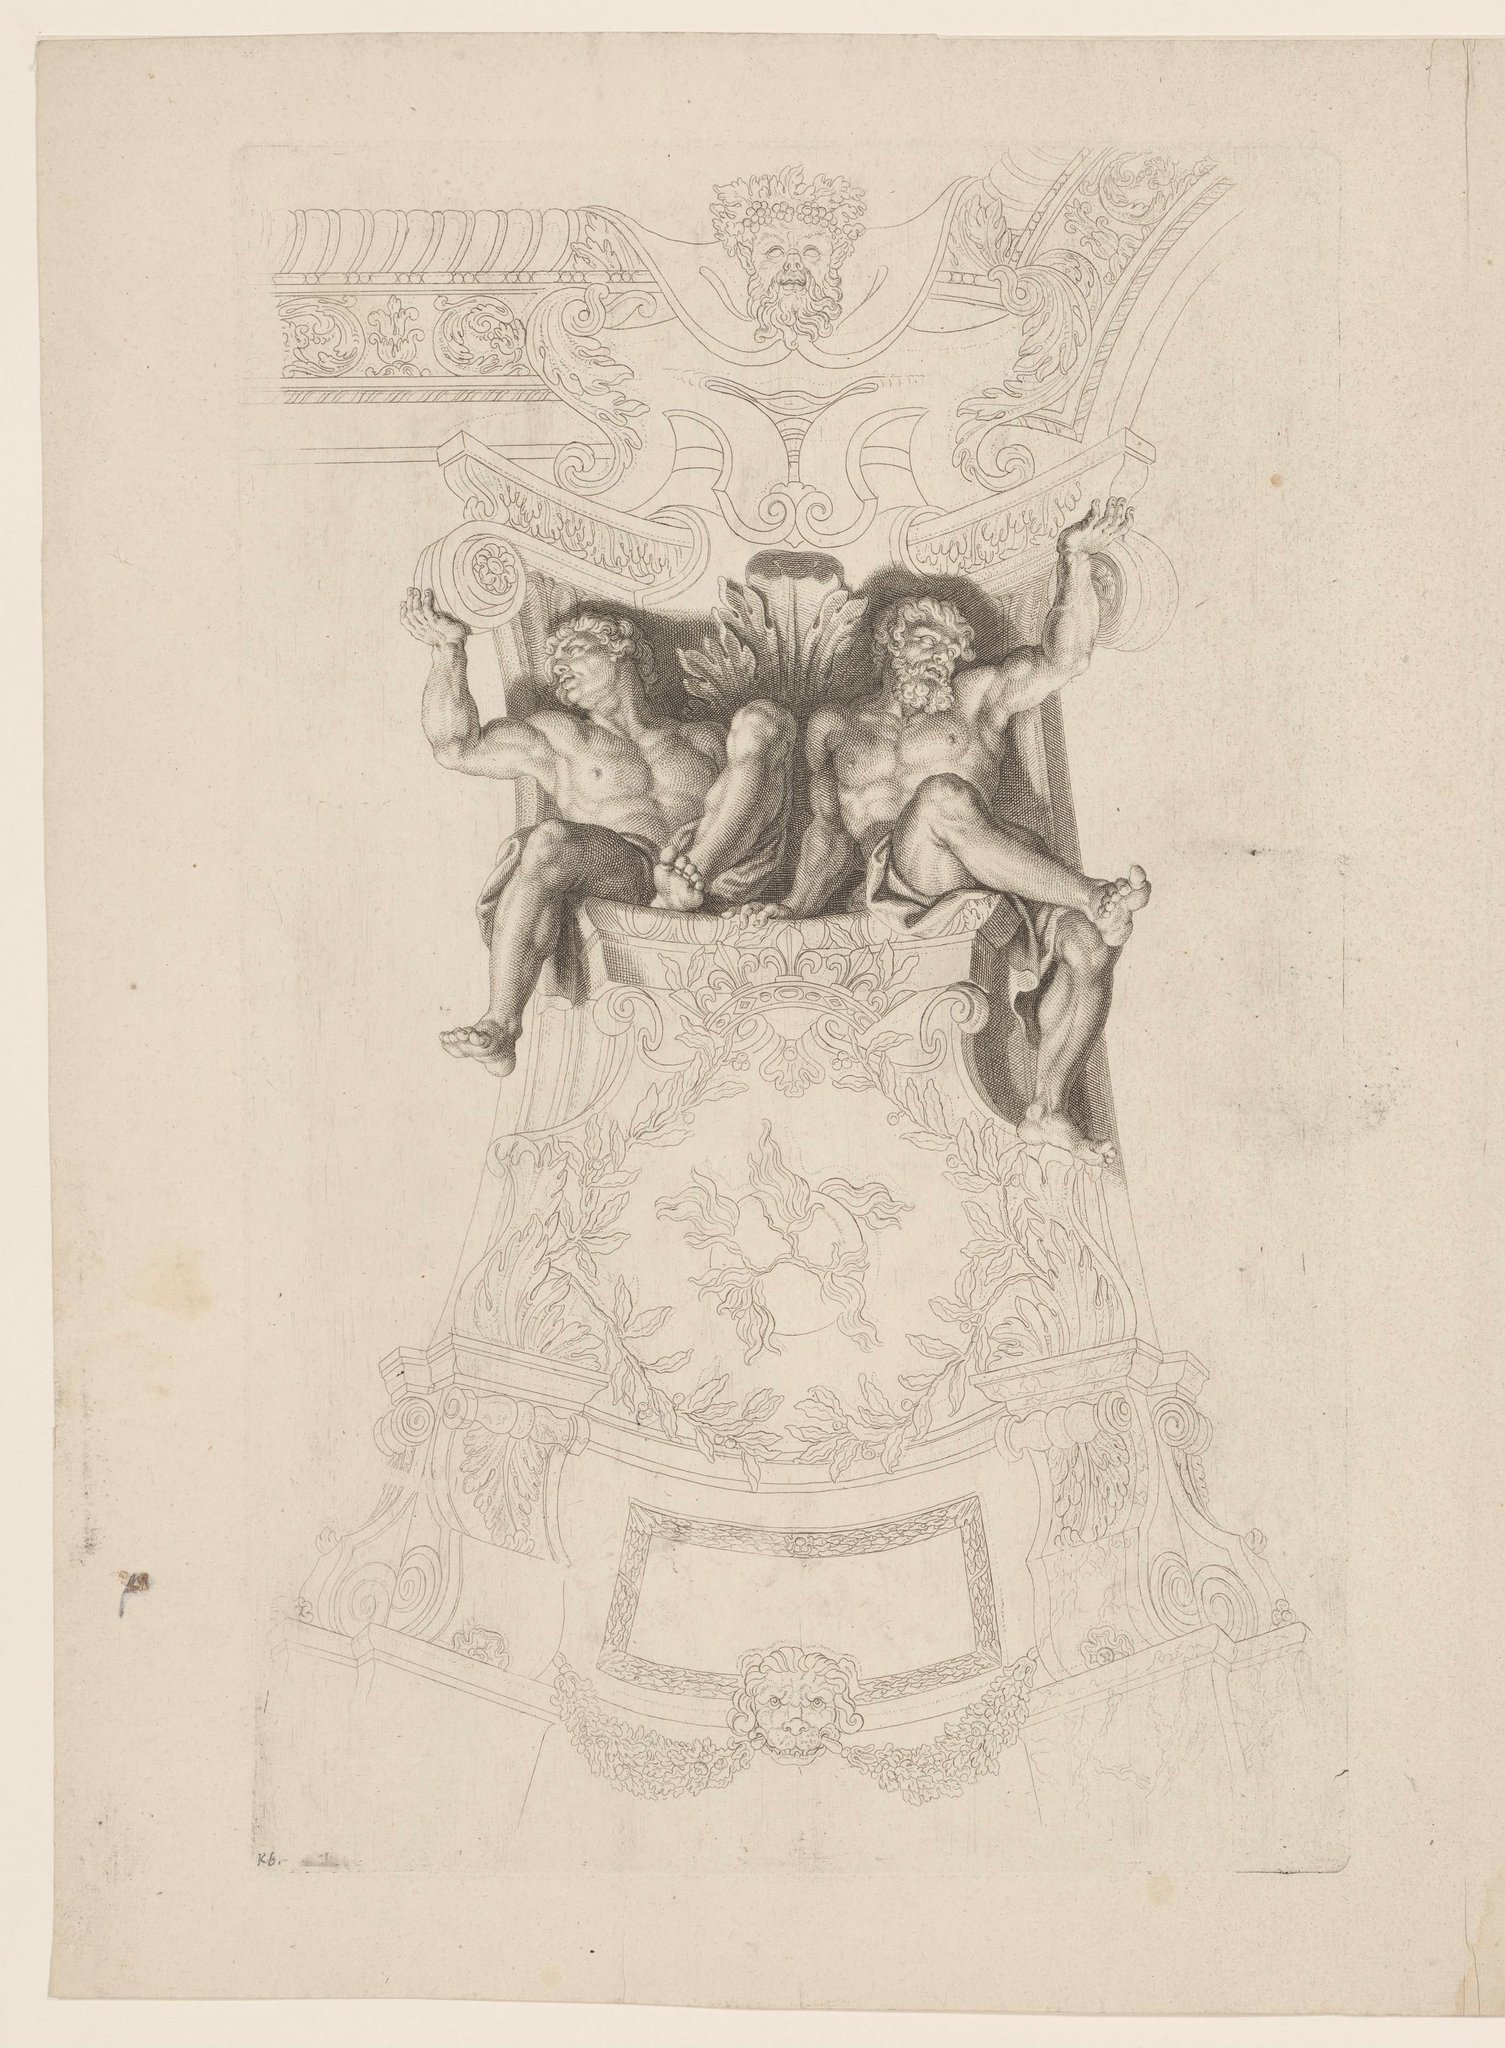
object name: print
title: Deel van een plafondschildering met twee naakte mannenfiguren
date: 1679-1728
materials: paper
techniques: engraving, etching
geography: paris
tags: man (showing himself) undressed, quasi-nude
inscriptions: collector's mark: Lugt 240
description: Onderdeel van een serie prenten die de wand- en plafondschildering in het kasteel van Saint-Cloud afbeelden.